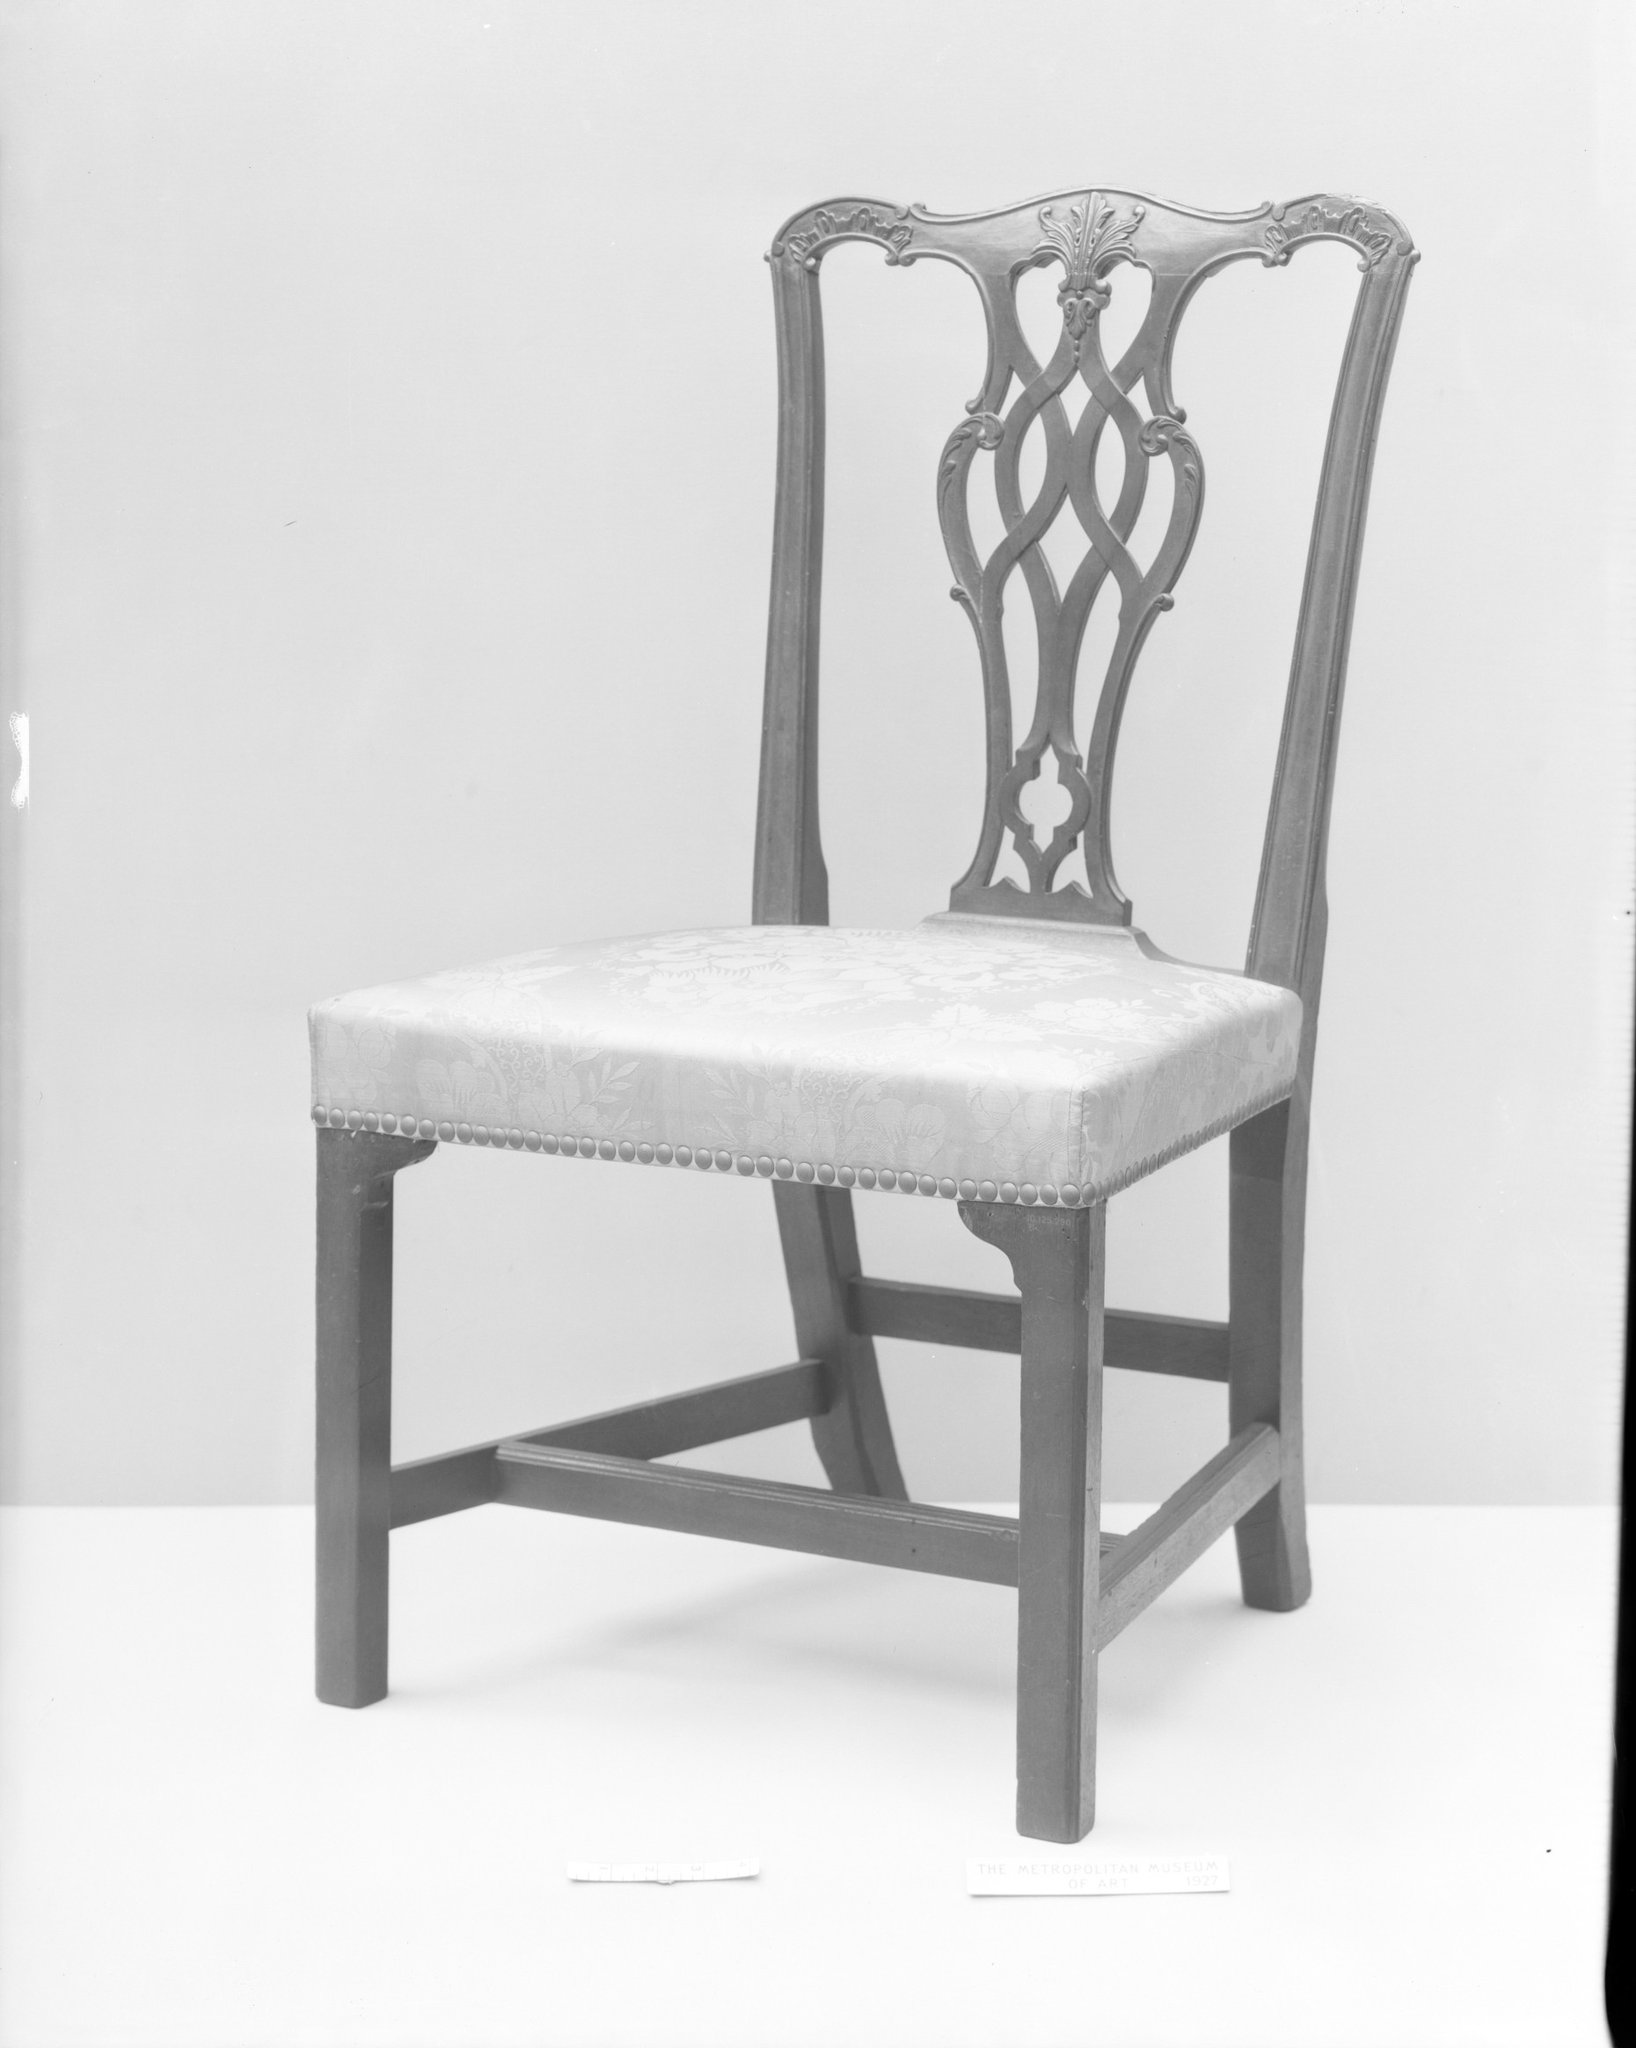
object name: side chair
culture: american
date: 1760-1790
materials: wood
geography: united states